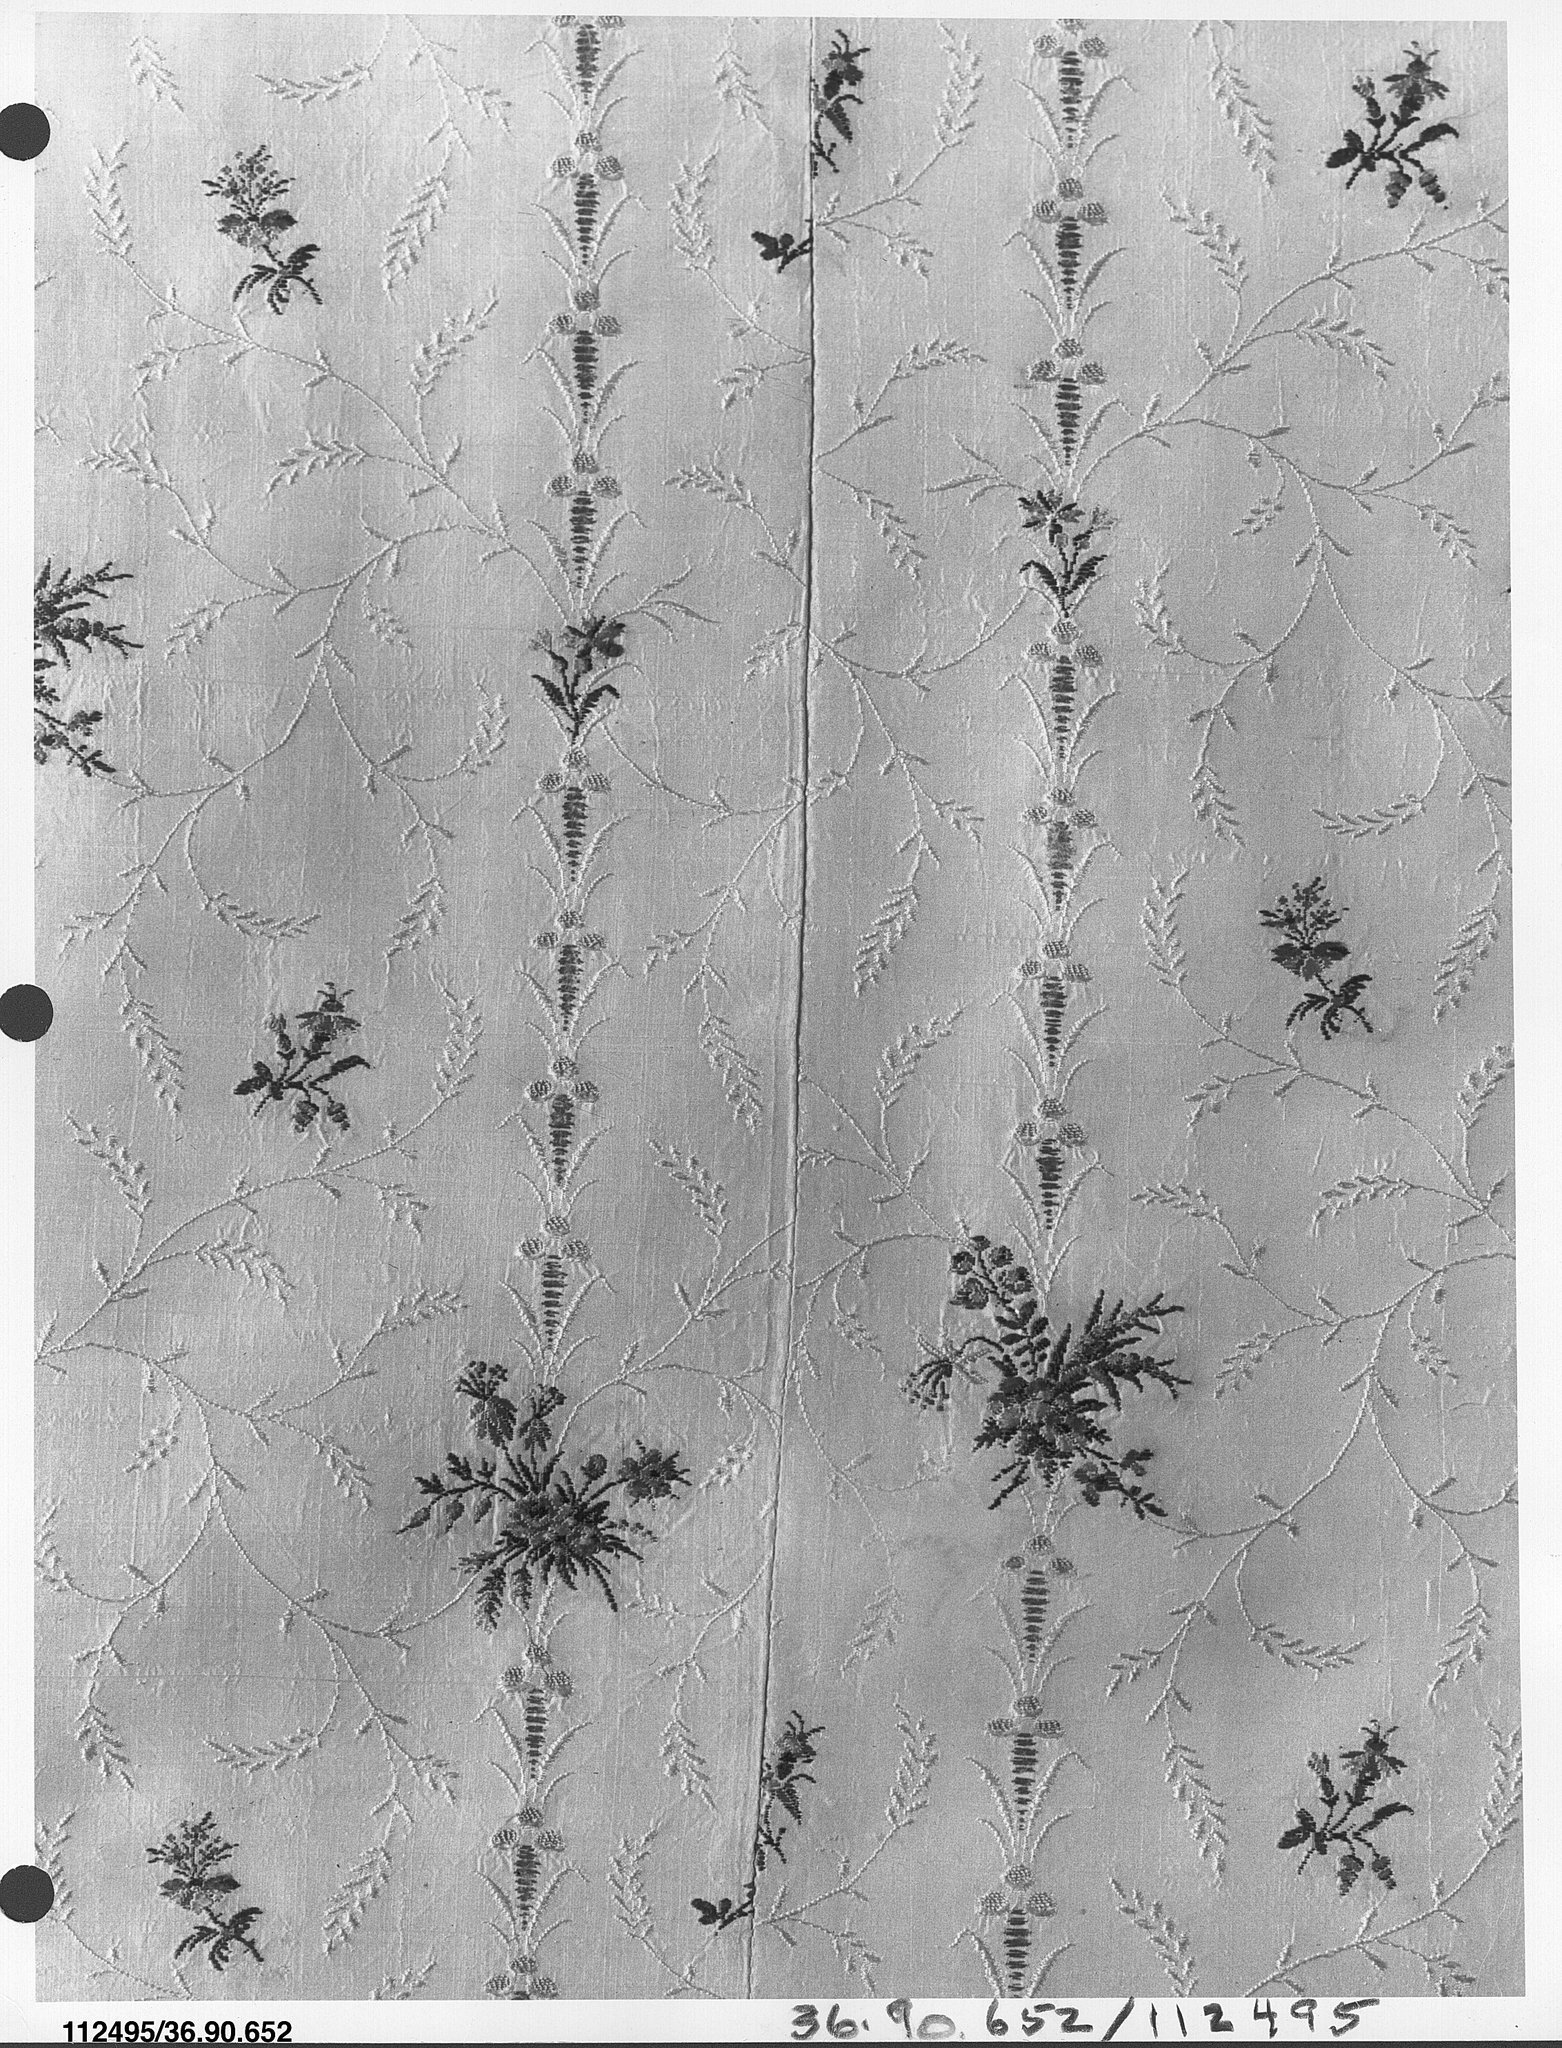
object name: piece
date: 1701-1800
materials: silk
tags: leaves